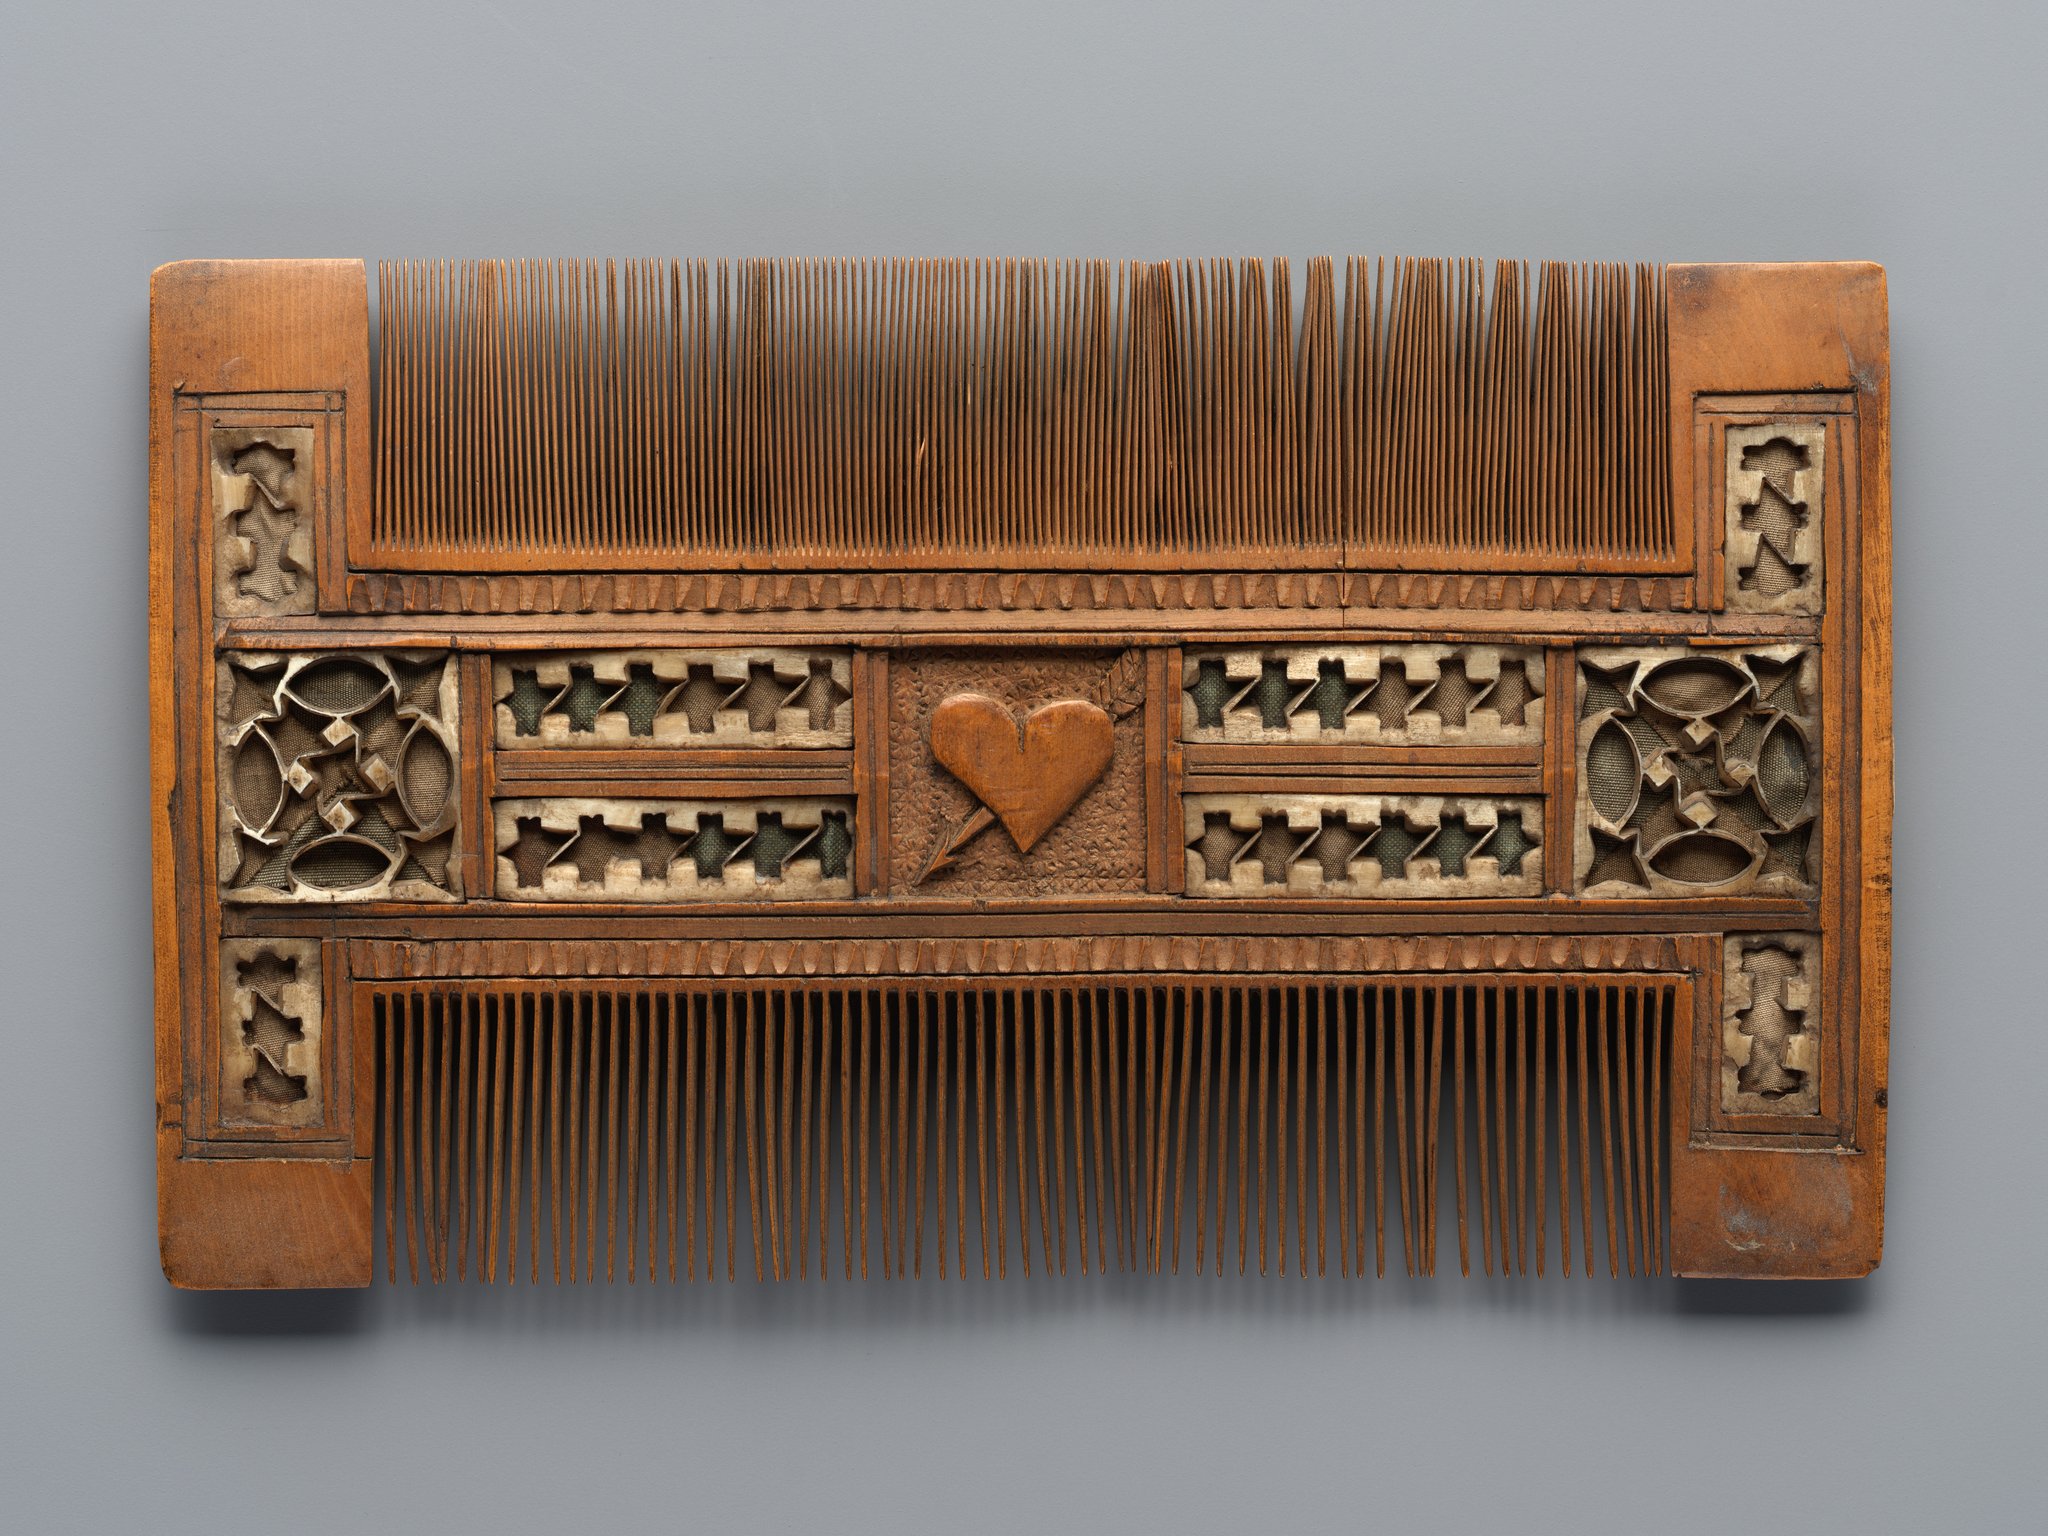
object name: comb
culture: french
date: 1401-1600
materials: bone, wood, silk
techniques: inlay